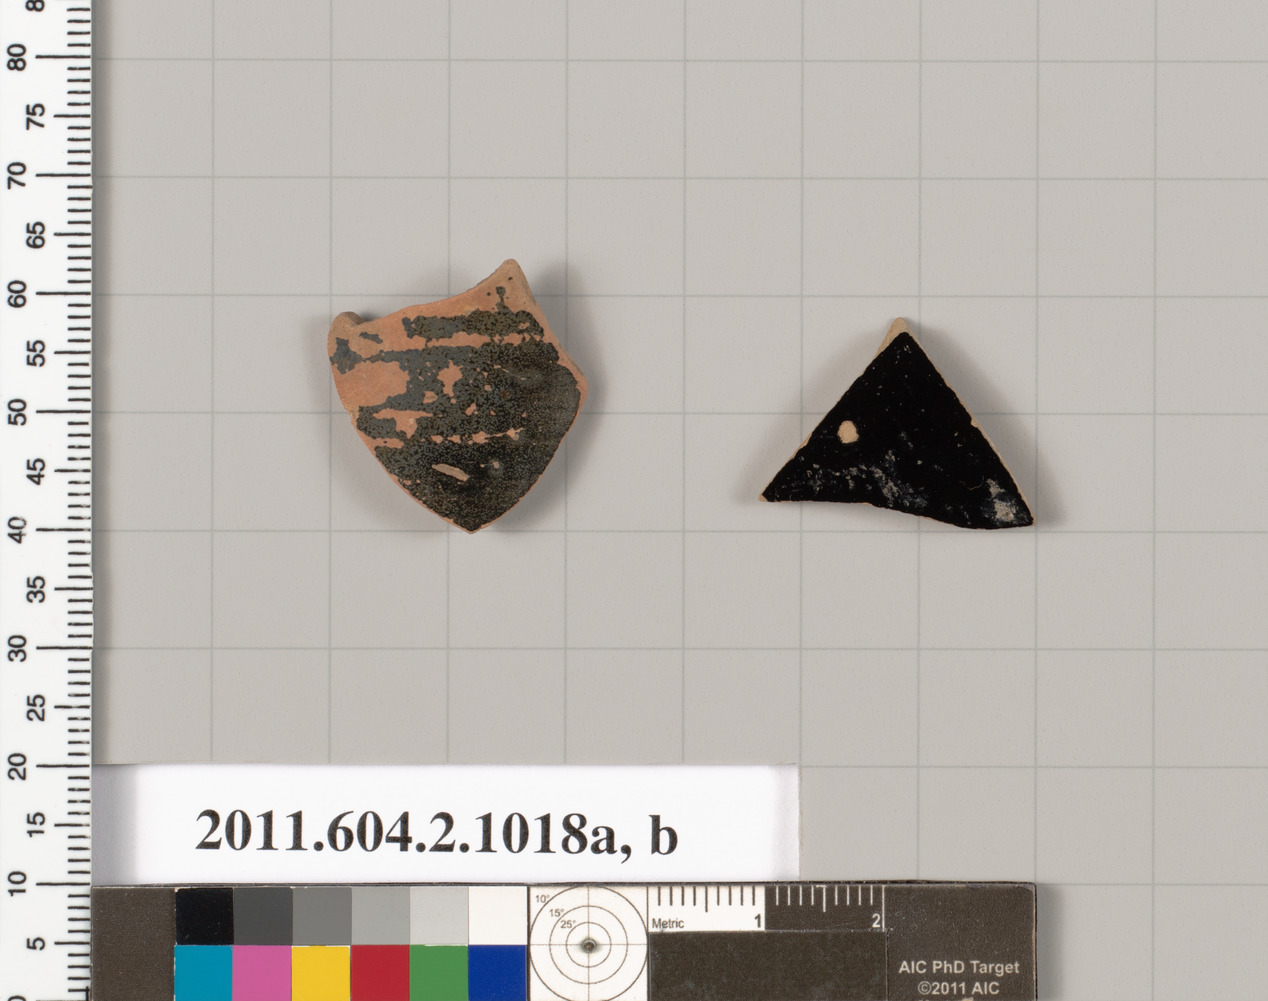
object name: oinochoe fragment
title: Terracotta fragments of oinochoai (jugs)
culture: greek, attic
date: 475-425 BCE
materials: terracotta